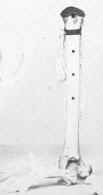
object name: wat sa pua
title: Wat-Sa-Pua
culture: native american or guyanese or demerara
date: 1801-1900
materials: bone, wax, wool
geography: guyana